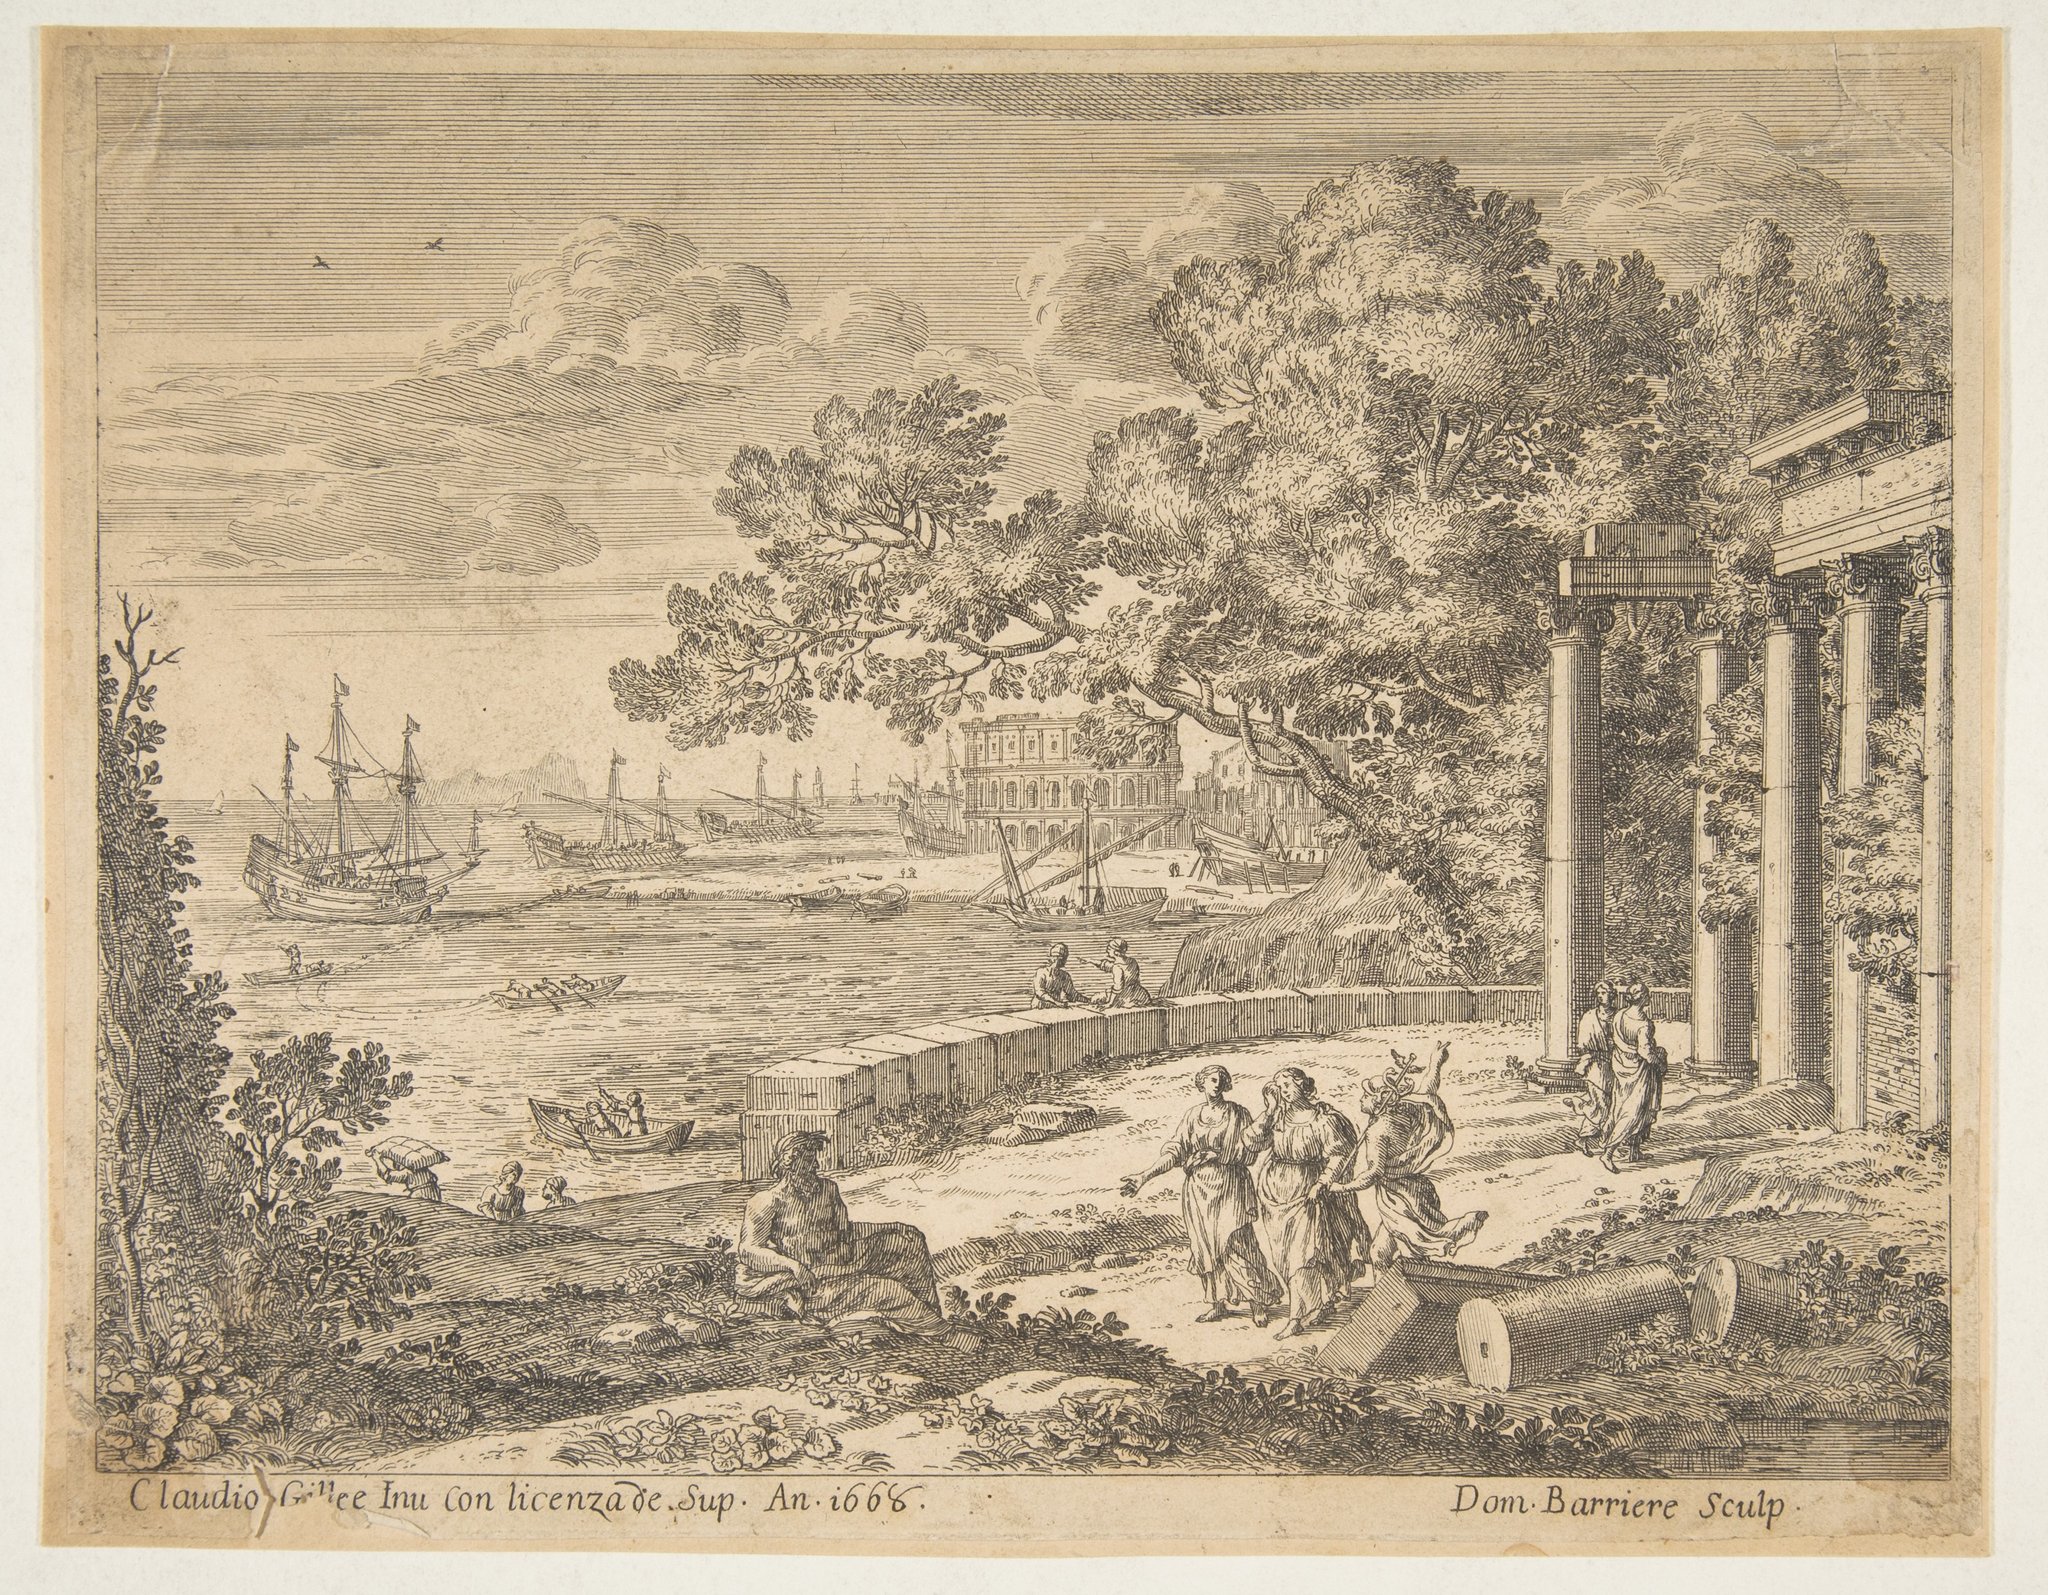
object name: print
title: Landscape with Mercury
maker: claude lorrain (claude gellée)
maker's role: artist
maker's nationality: french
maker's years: 1604-1682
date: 1668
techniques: etching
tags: men,women,mercury,landscapes,ships